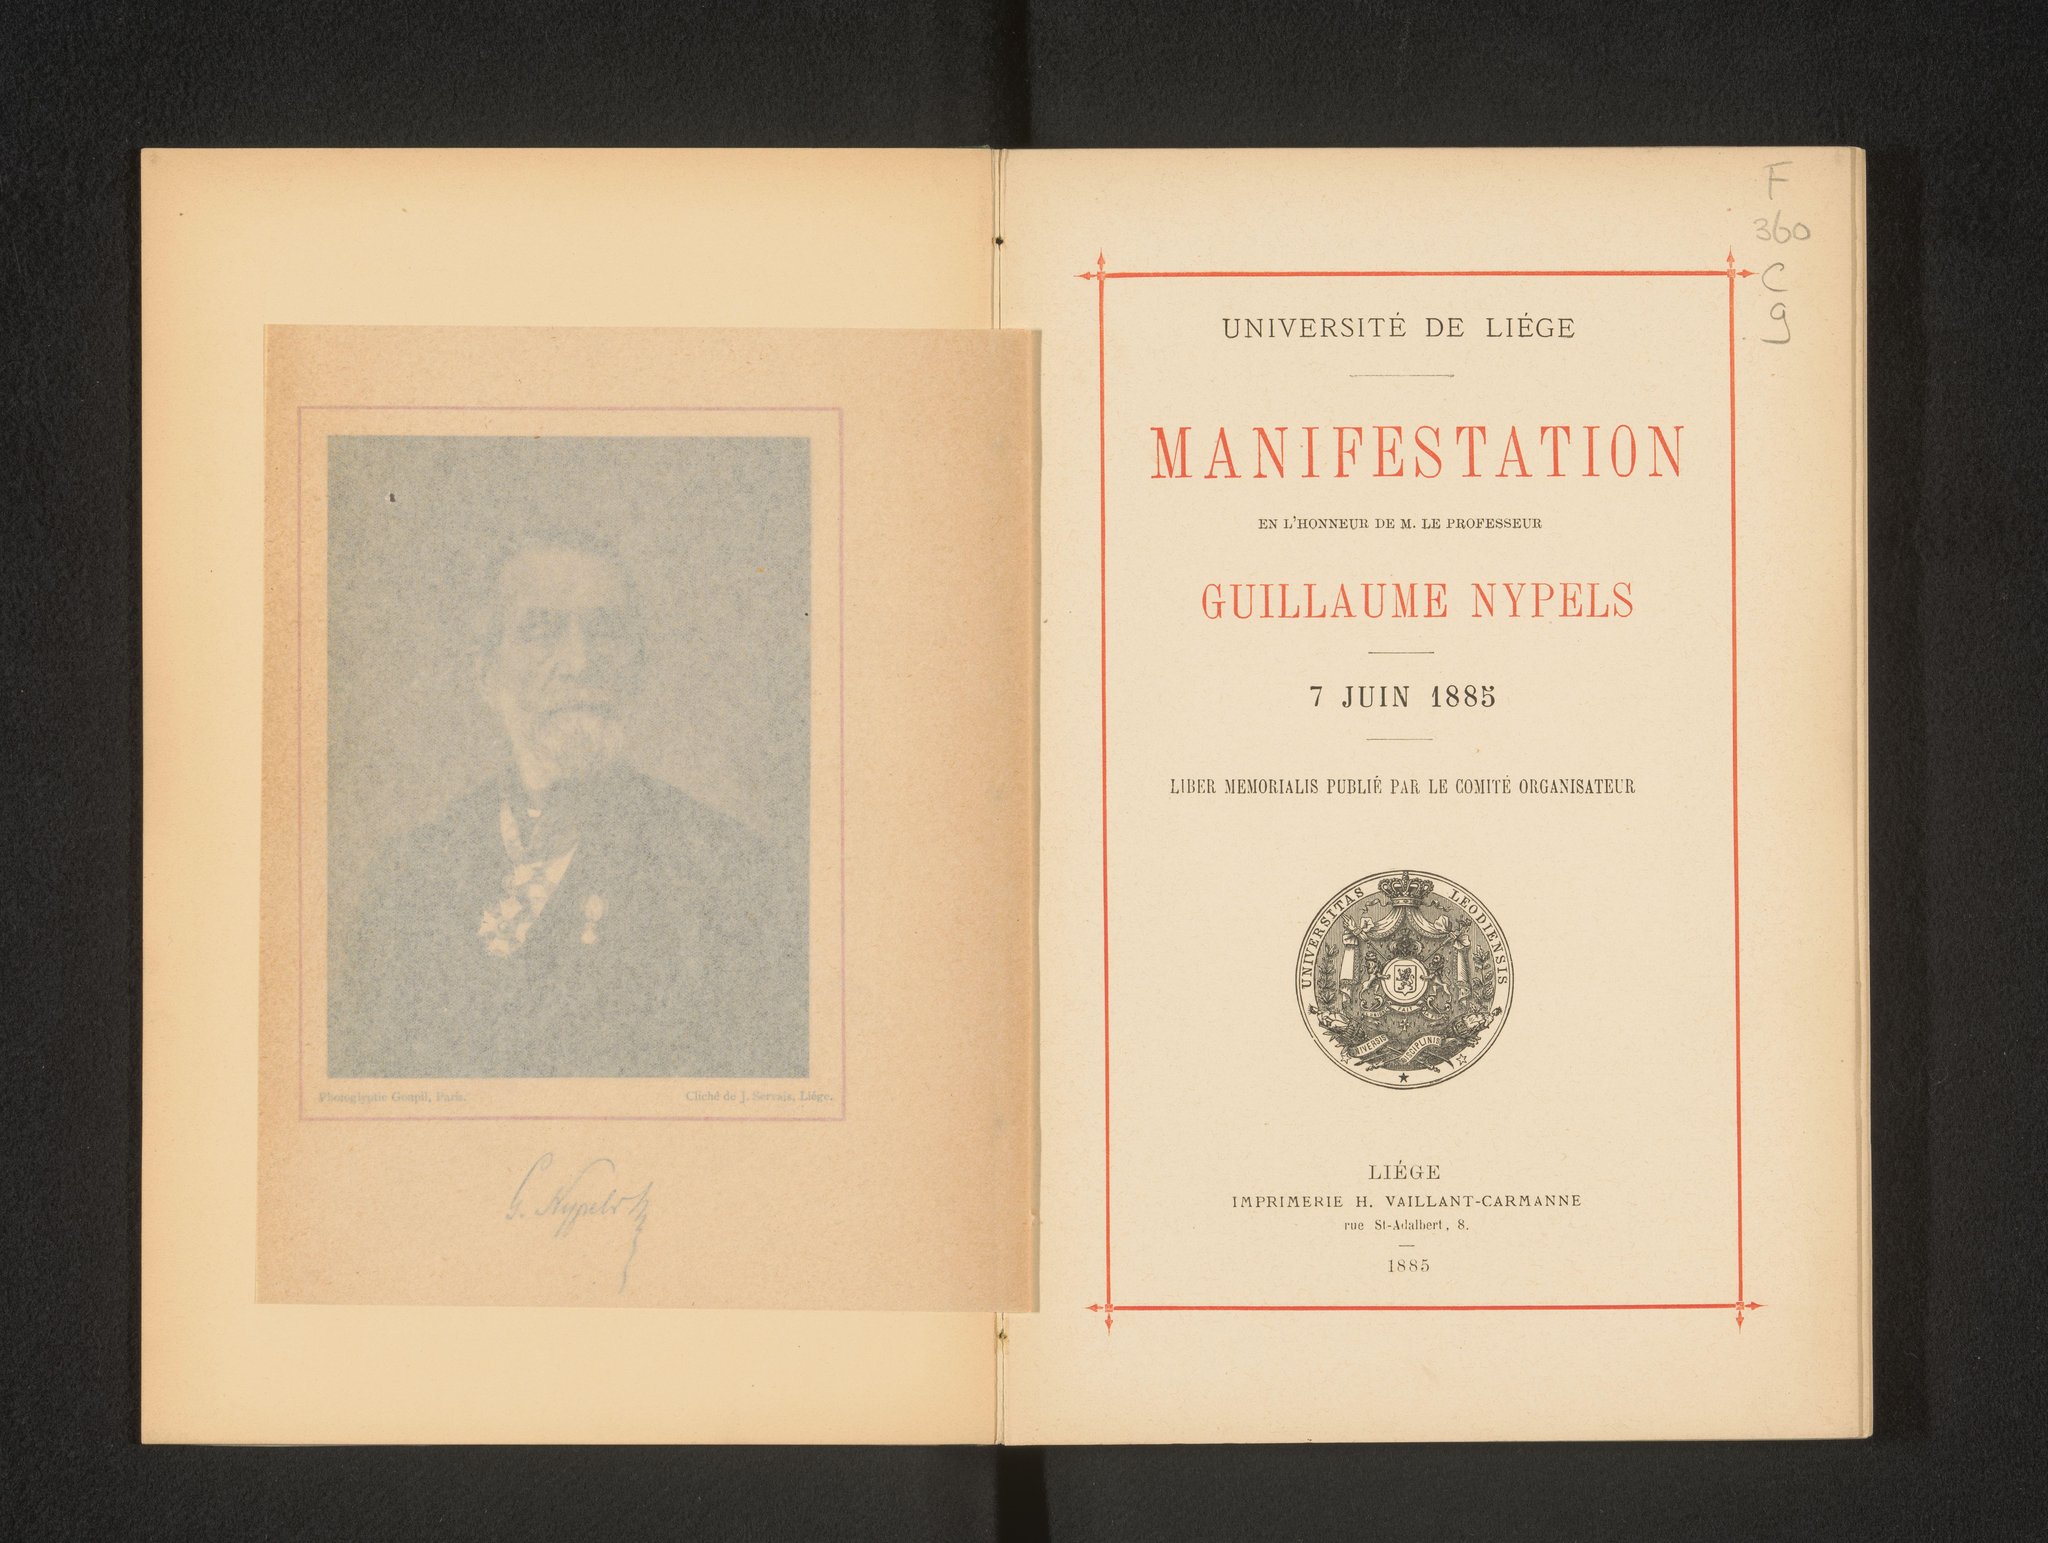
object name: book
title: Manifestation en l'honneur de M. le professeur Guillaume Nypels, 7 juin 1885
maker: h. vaillant-carmanne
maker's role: publisher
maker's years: 1838-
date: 1885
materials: cardboard, paper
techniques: printing, woodburytype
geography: liège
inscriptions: collector's mark: ‘College/ Saint-Servais/ Liége/ 55A3’, annotation: ‘NOV 1999’